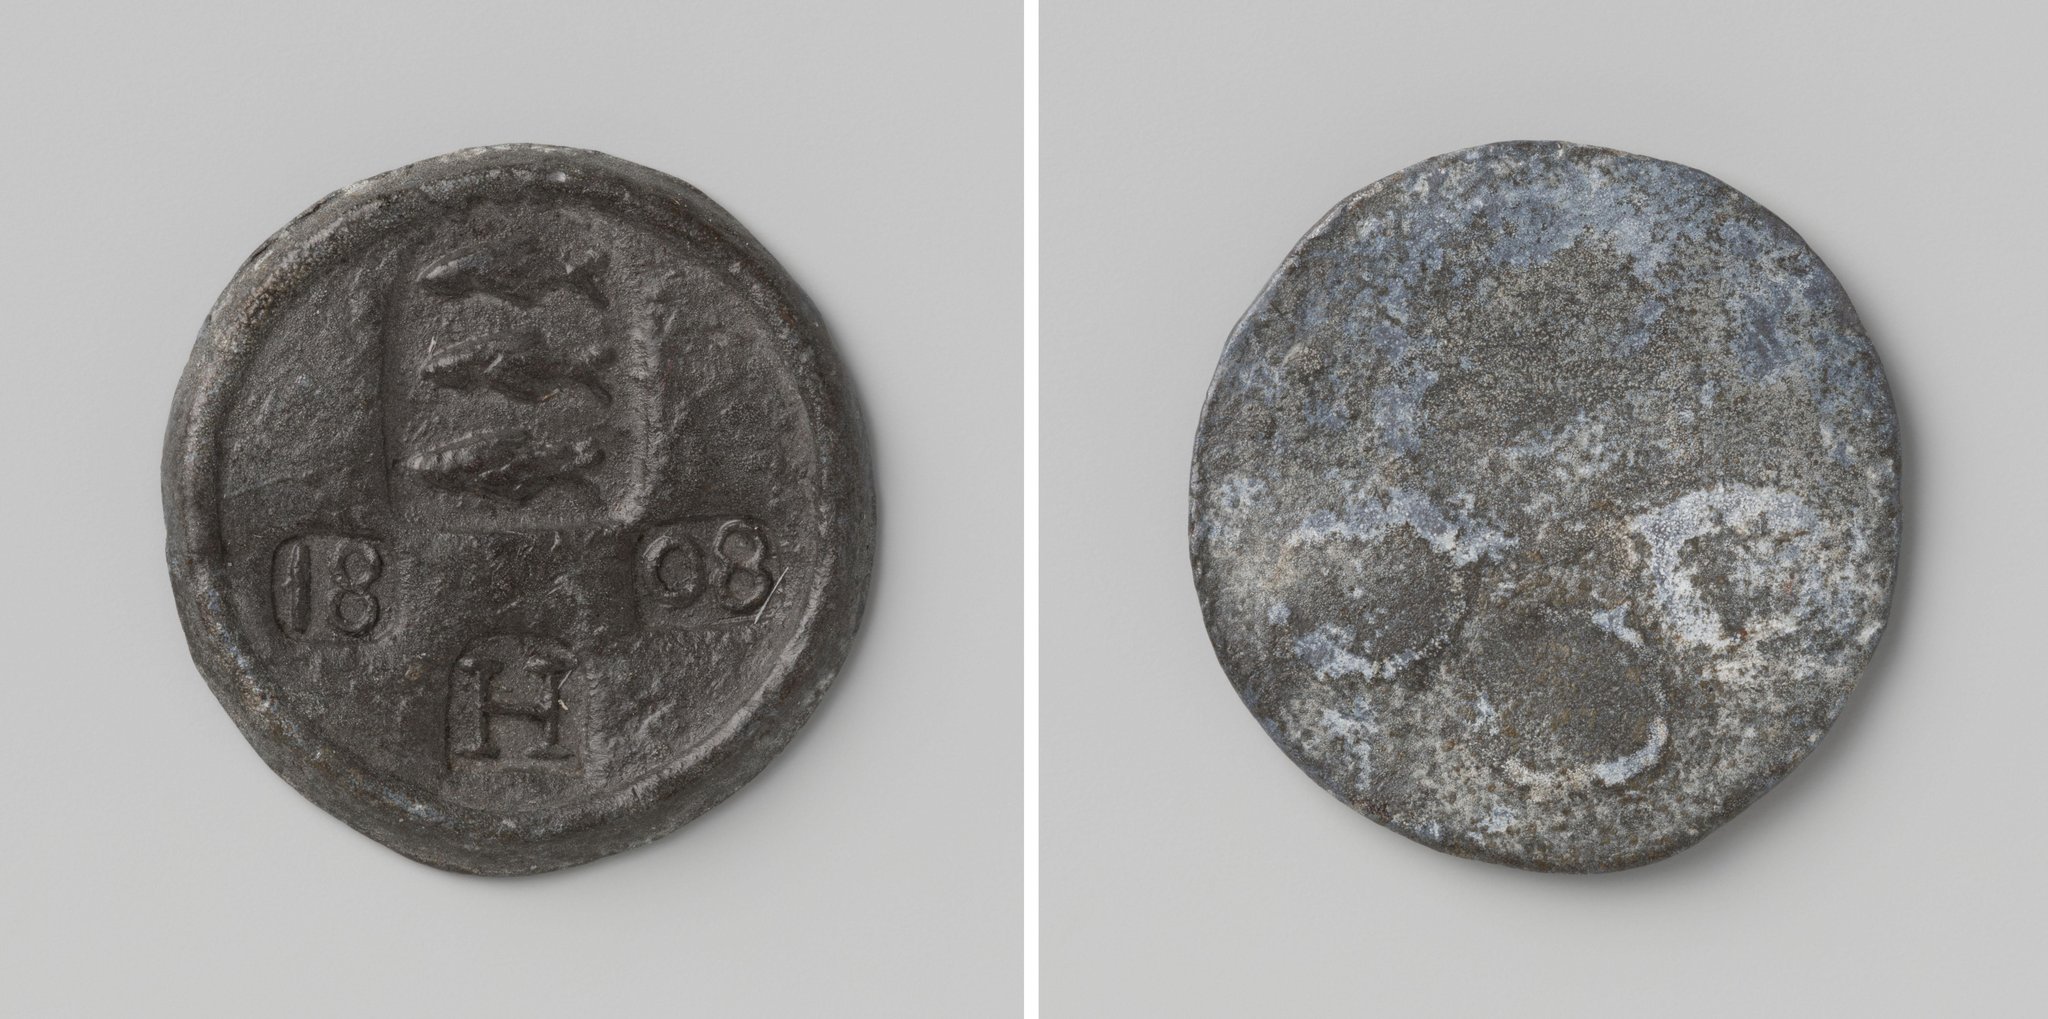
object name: tax token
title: Loden penning van Enkhuizen, met letter H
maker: Anonymous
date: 1808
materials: lead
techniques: casting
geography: enkhuizen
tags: enkhuizen